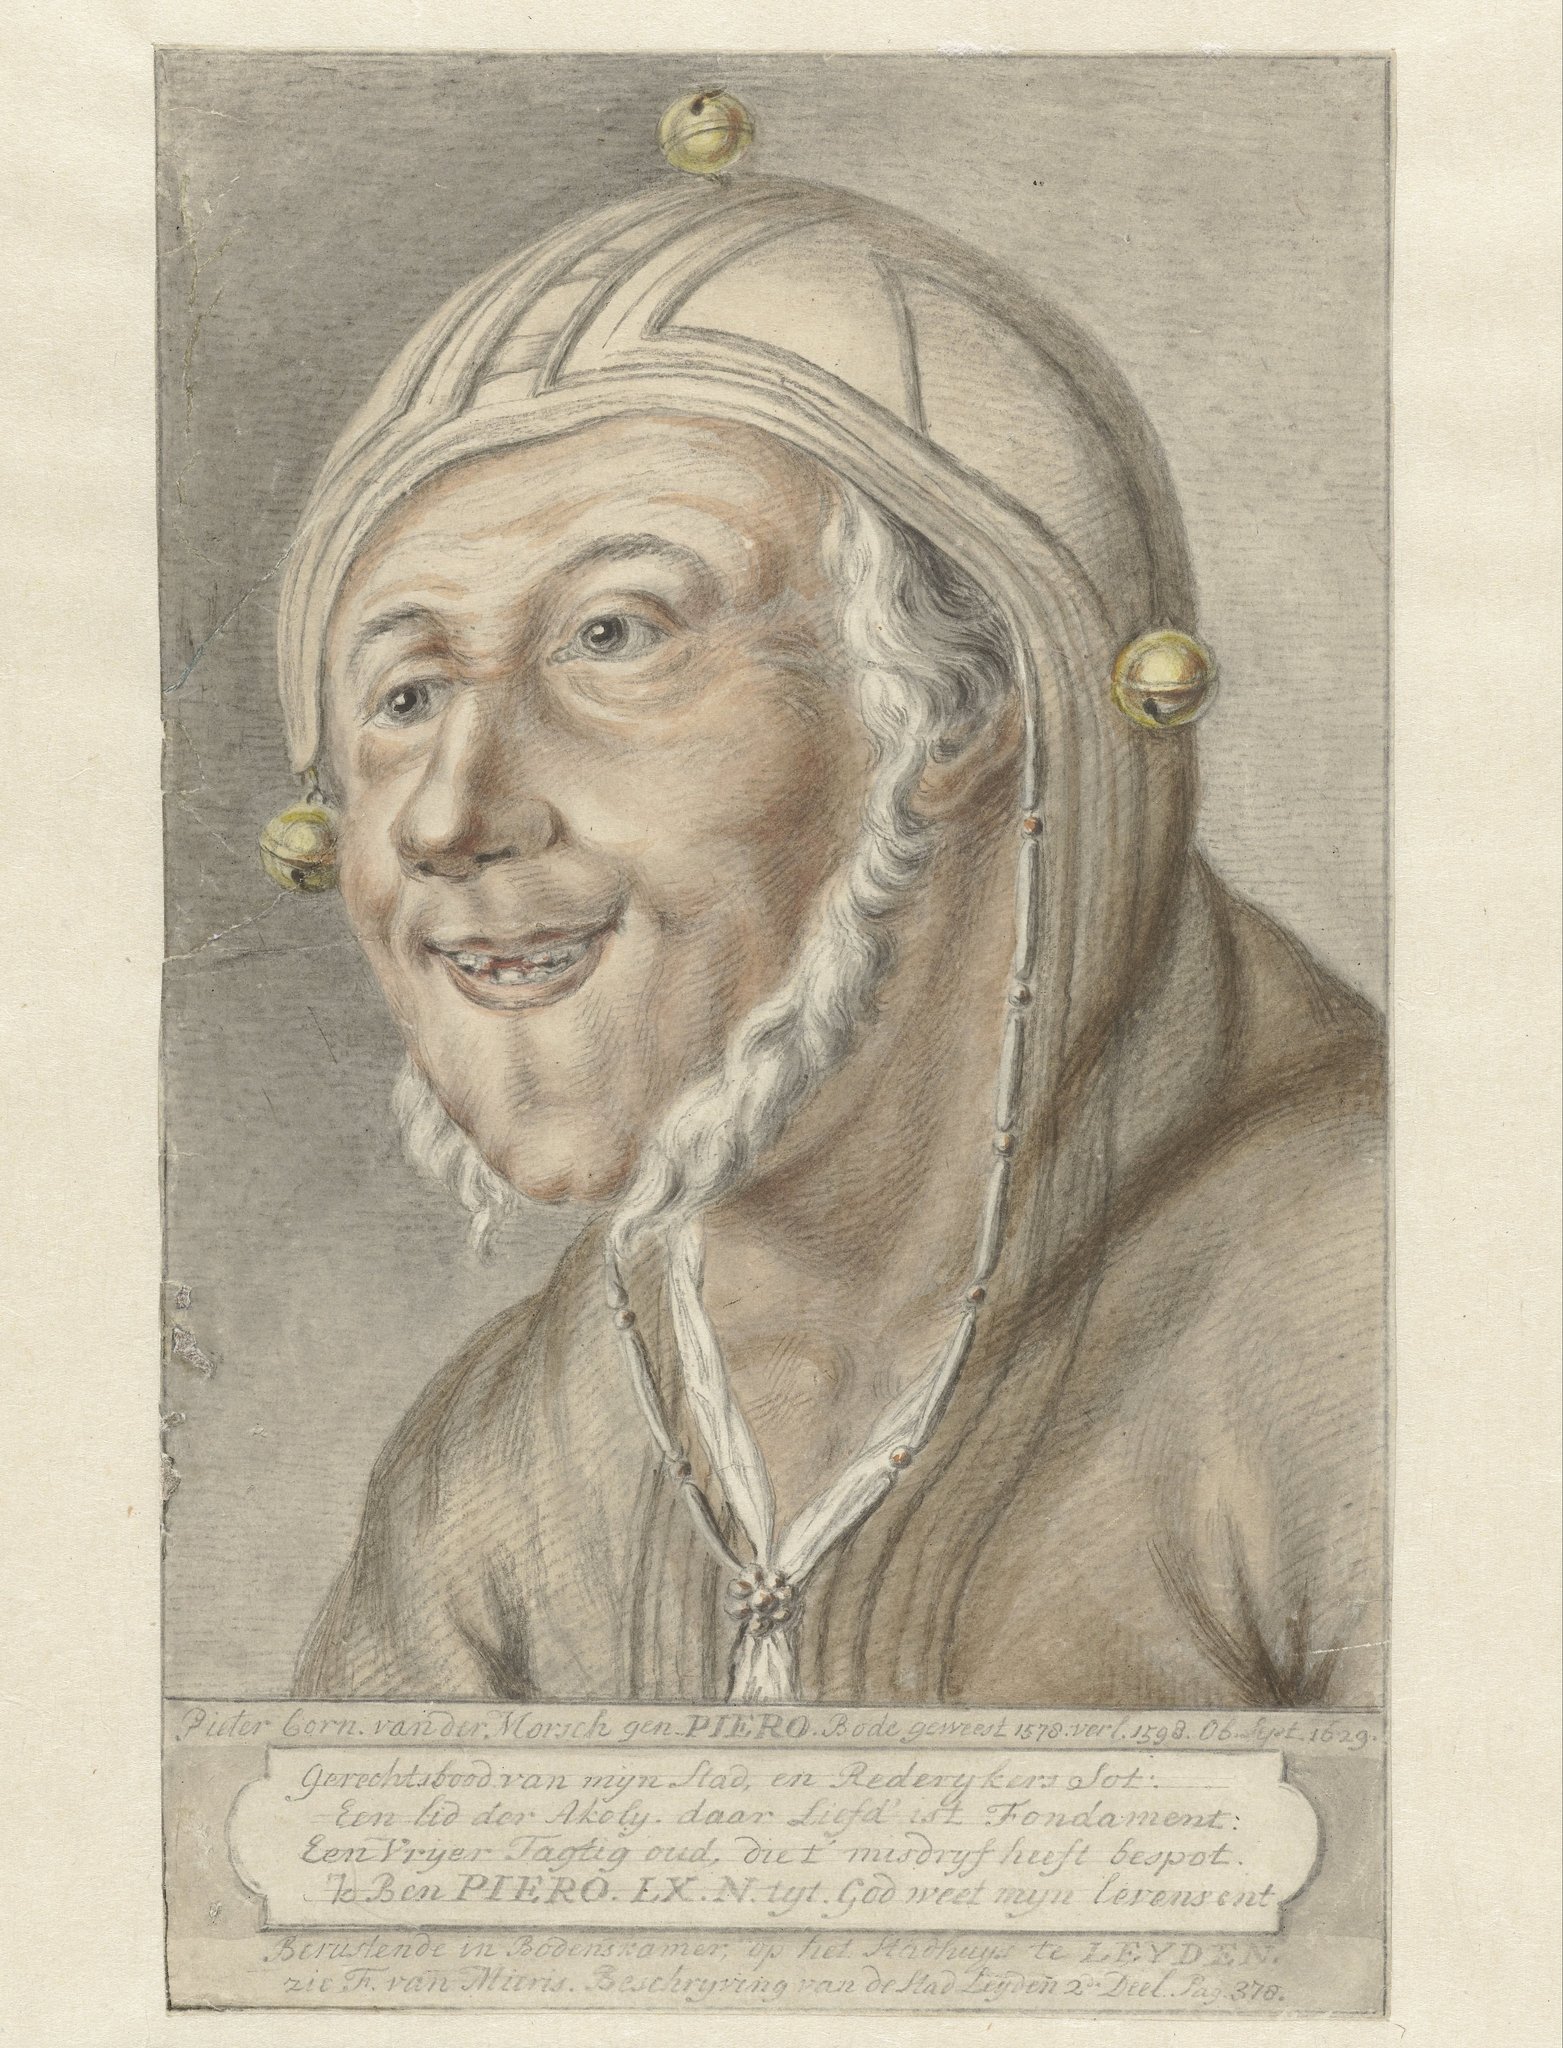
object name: watercolor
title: Portret van Pieter Cornelisz. van der Morsch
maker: abraham delfos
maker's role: draughtsman, painter, print maker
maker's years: 1731-1820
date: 1741-1820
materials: chalk, paper, pencil, watercolor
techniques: brush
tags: leiden, historical persons, fool's cap